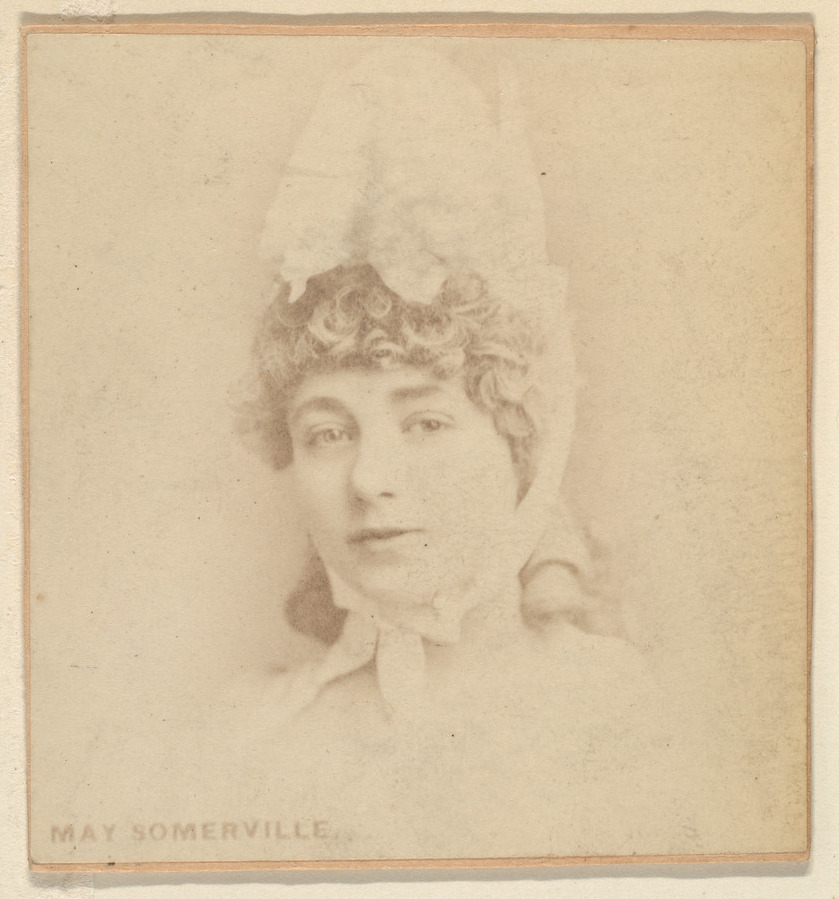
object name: photograph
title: May Somerville, from the Actresses series (N246), Type 2, issued by Kinney Brothers to promote Sporting Extra Cigarettes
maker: kinney brothers tobacco company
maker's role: publisher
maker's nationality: american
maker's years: 1869-2011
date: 1890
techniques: albumen silver print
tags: portraits,women,actresses